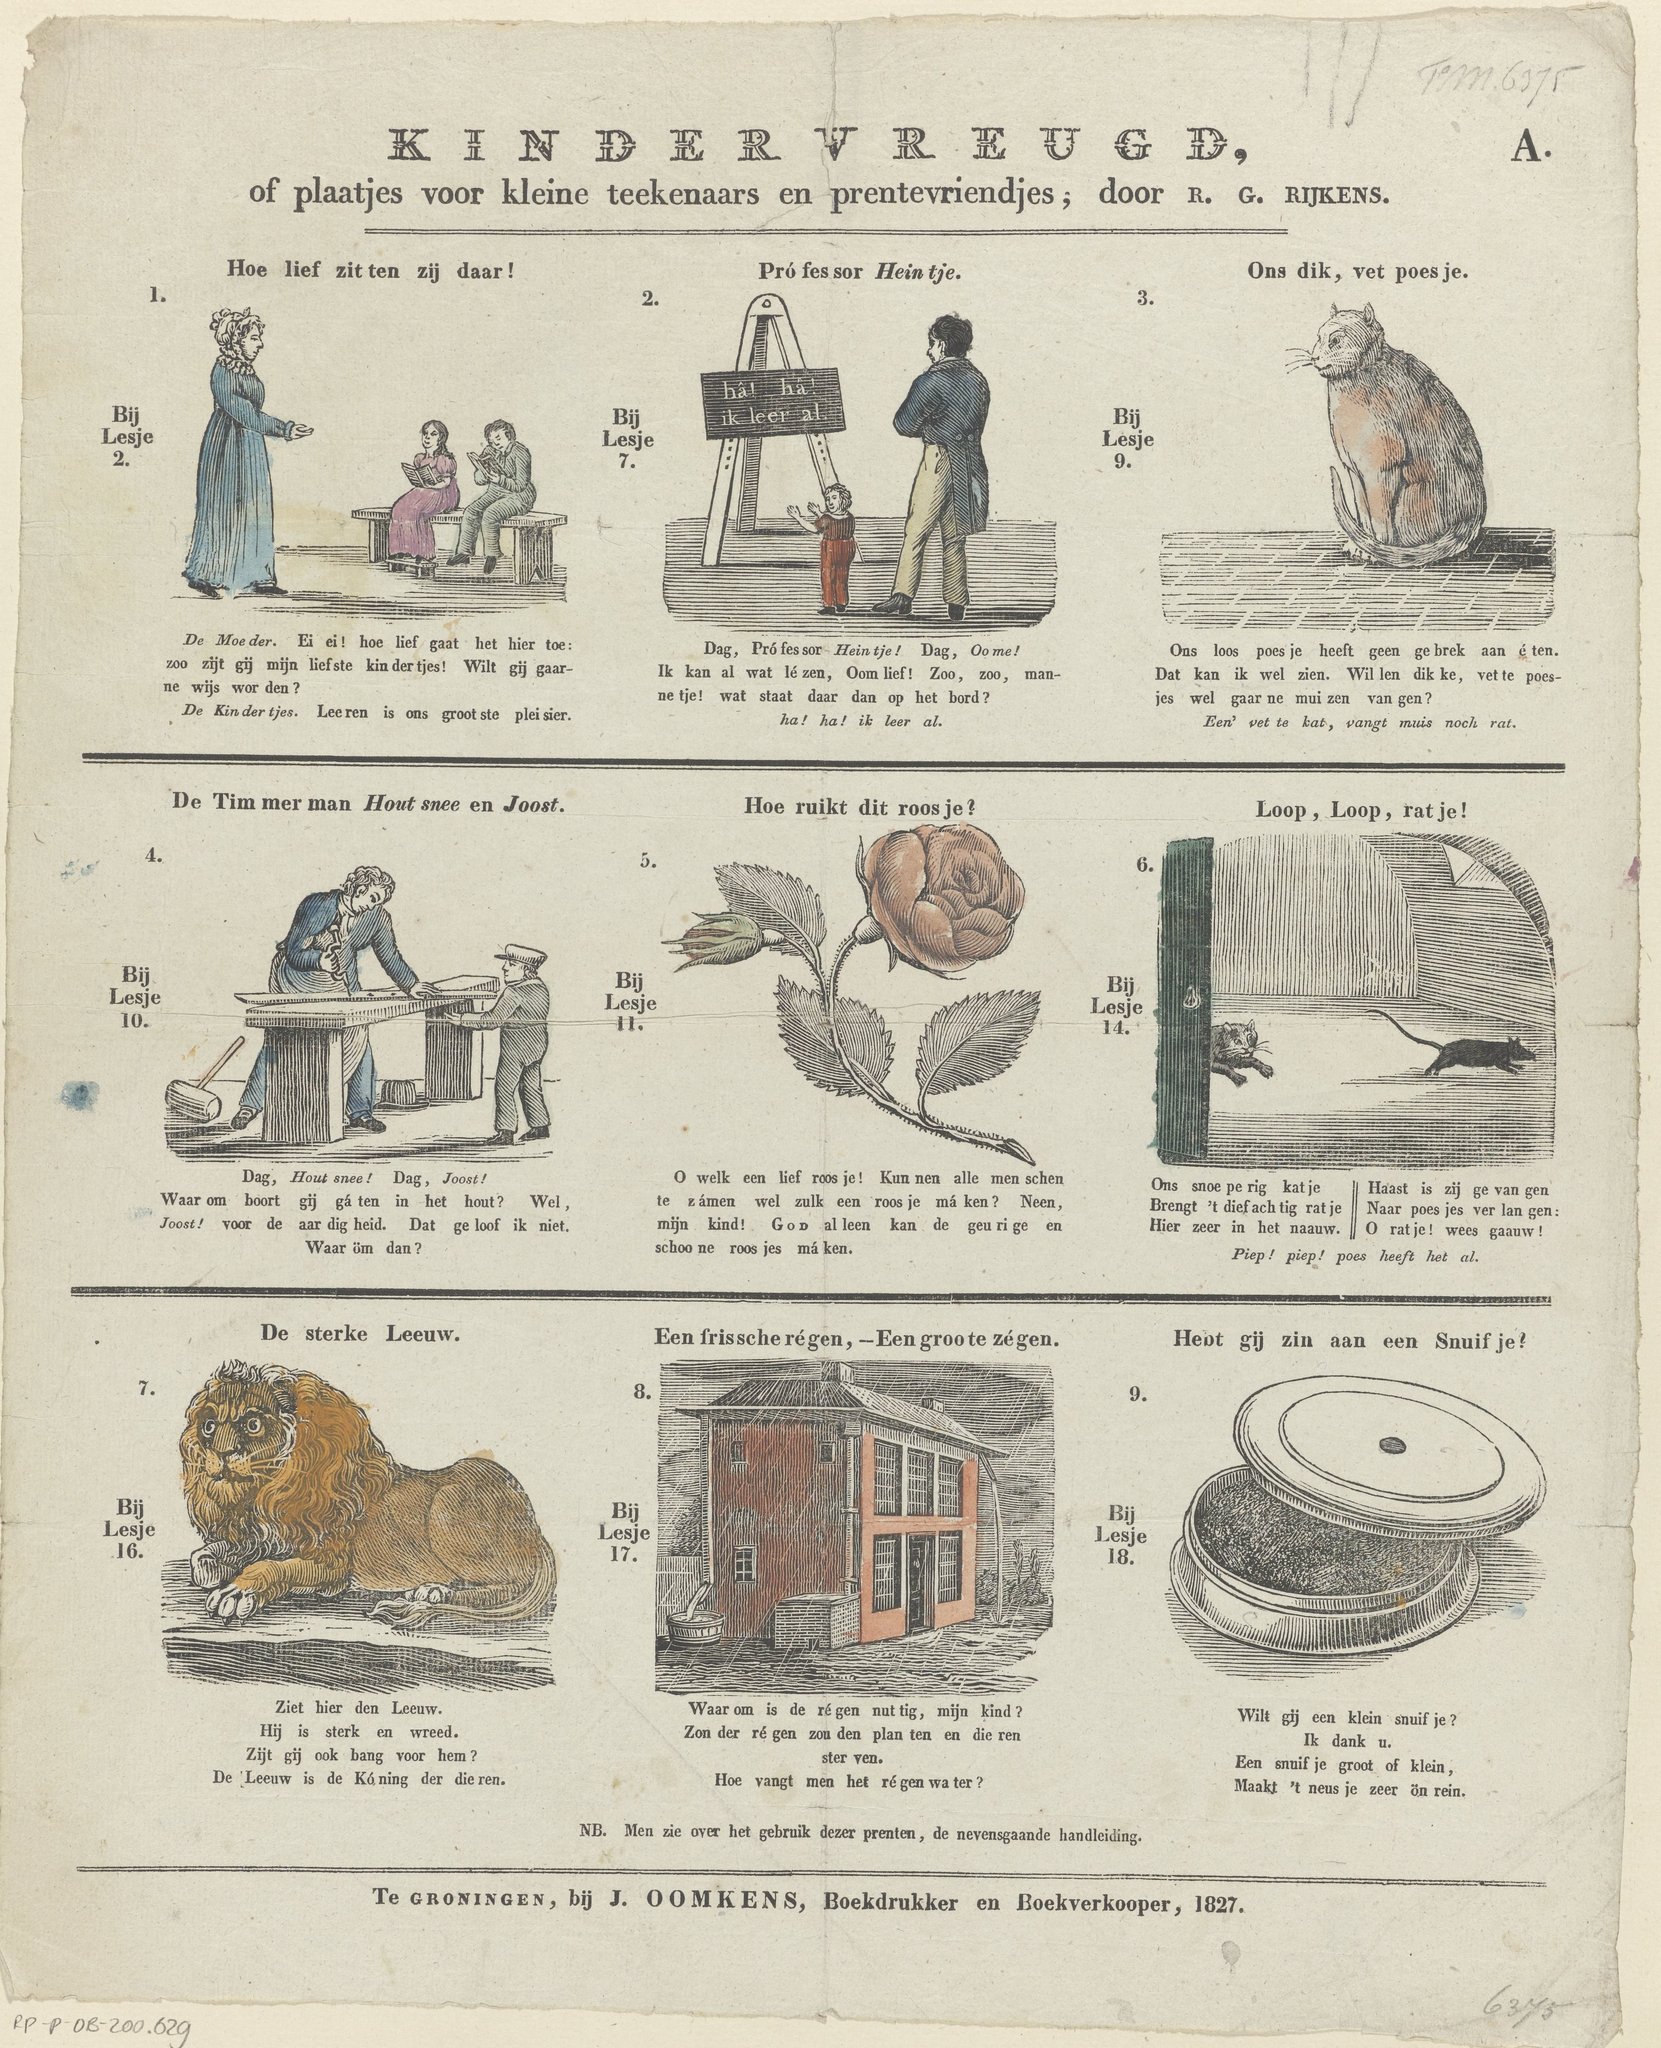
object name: print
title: Hoe lief zitten zij daar! (...)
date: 1827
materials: paper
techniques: colour, letterpress printing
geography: netherlands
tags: cat, rain, flowers: rose, education, beasts of prey, predatory animals: lion, cat and mouse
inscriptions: date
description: Blad met 9 illustraties (genummerd 1-9) bij leesboekjes van R.G. Rijkens. Elk plaatje hoort bij een lesje uit de boekjes "Natuurlijke Lees-Leerwijze". Weergegeven zijn ondermeer een kat, een roos, regen en een leeuw. Boven elke afbeelding een nummer en een titel en onder elke afbeelding een vierregelig vers. Links van elke afbeelding staat vermeld bij welke les het plaatje hoort. Gemerkt rechtsboven: A.